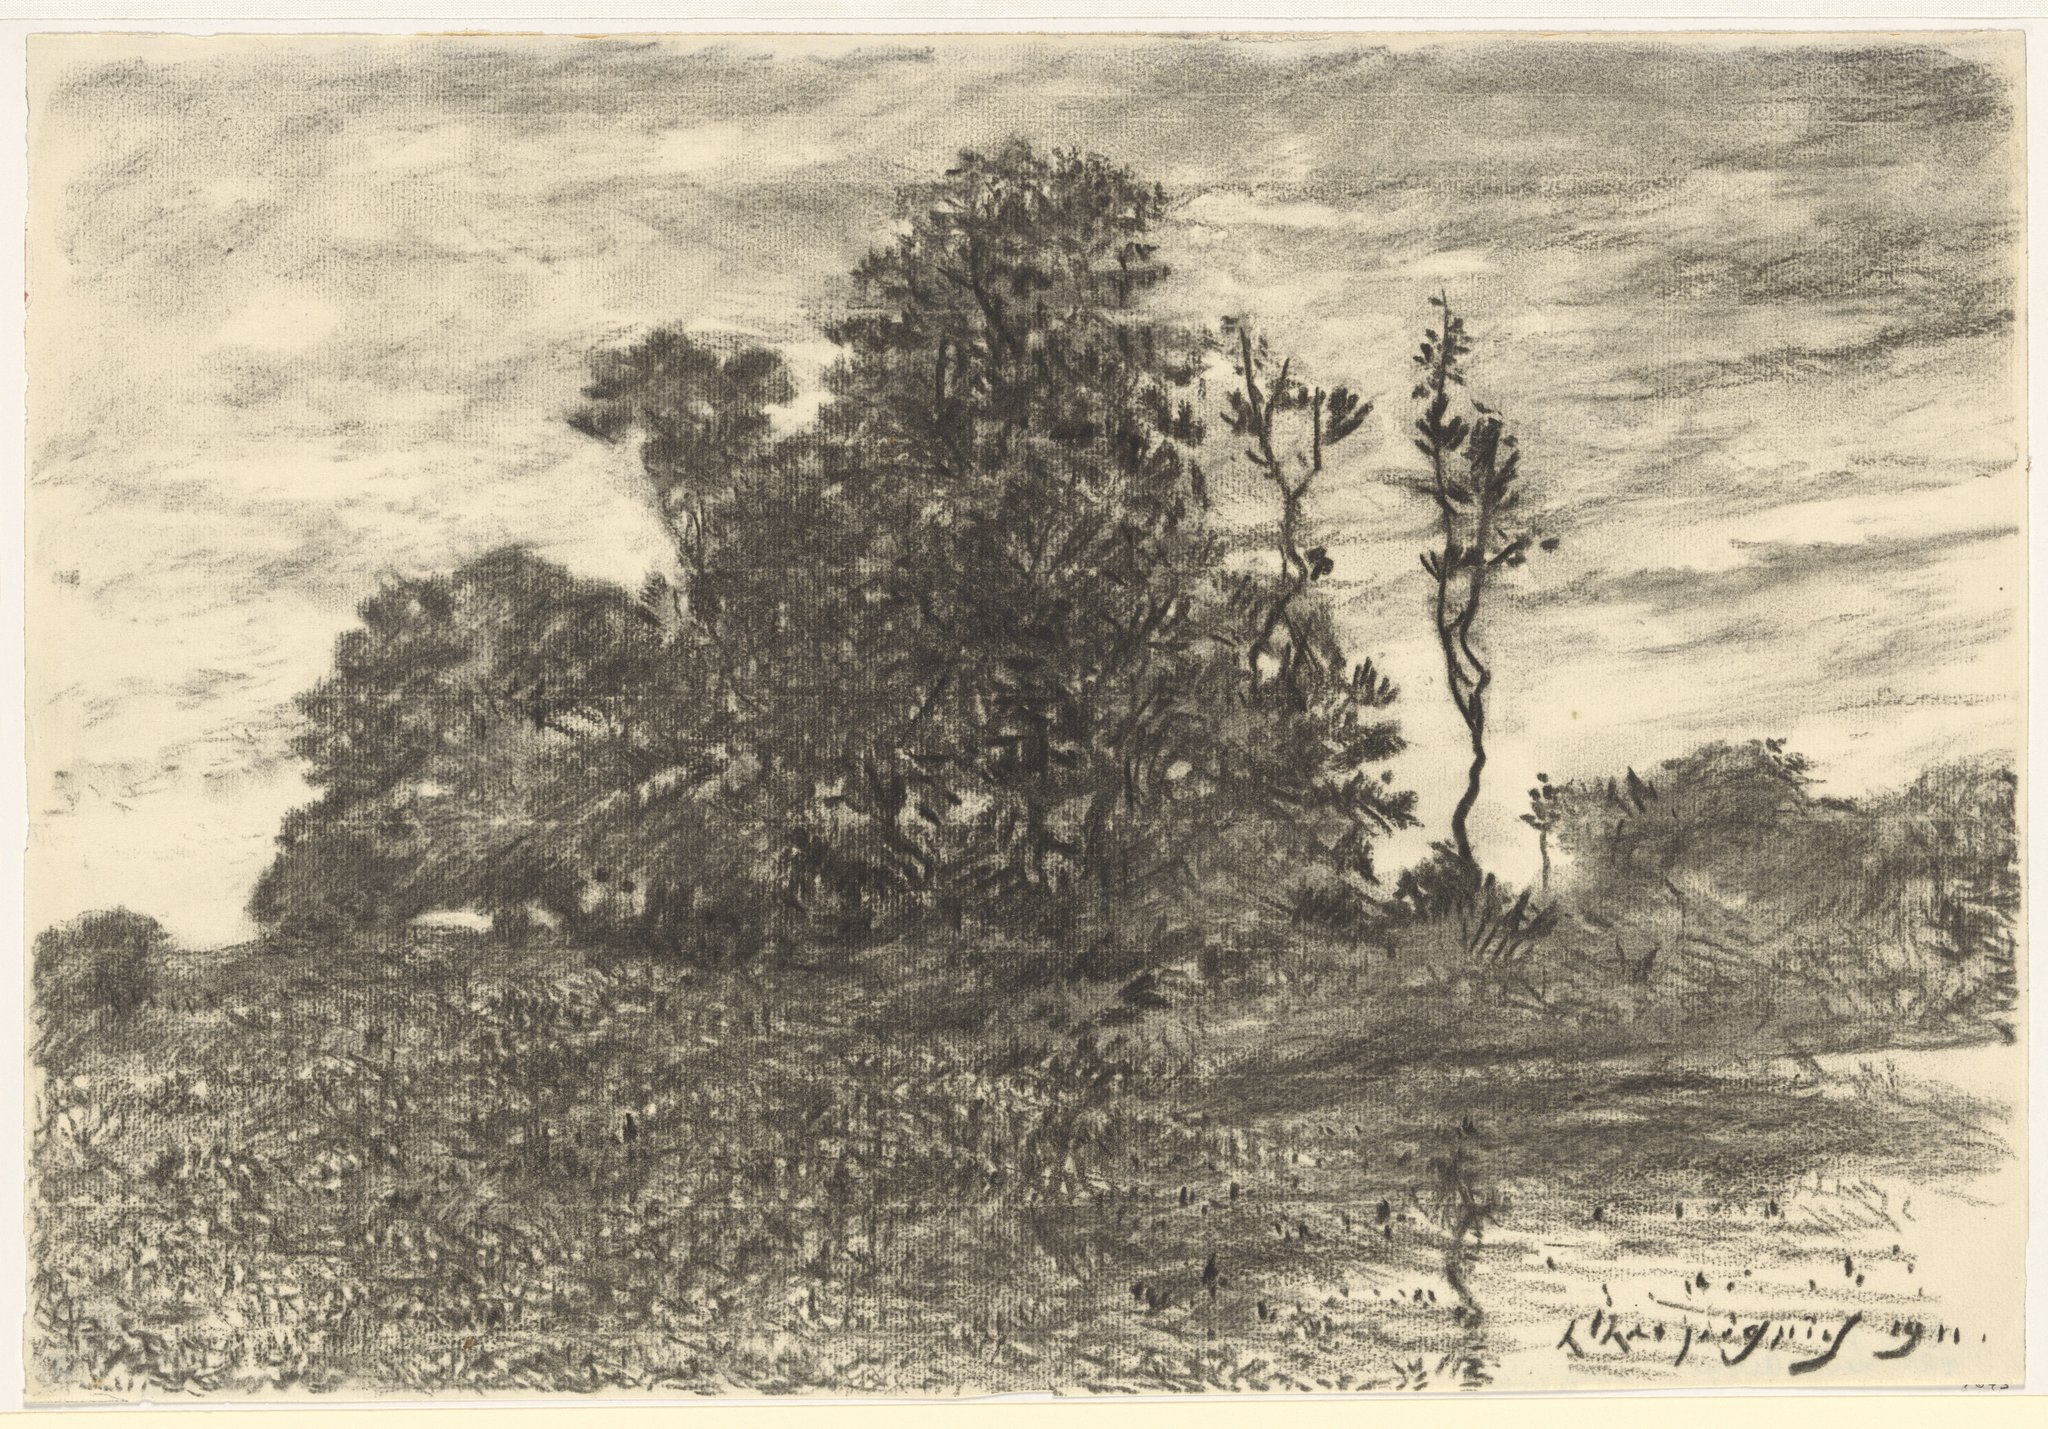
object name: drawing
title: The Pond at Les Luneaux, Allier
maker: henri-joseph harpignies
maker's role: artist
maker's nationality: french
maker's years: 1819-1916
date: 1911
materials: charcoal, paper